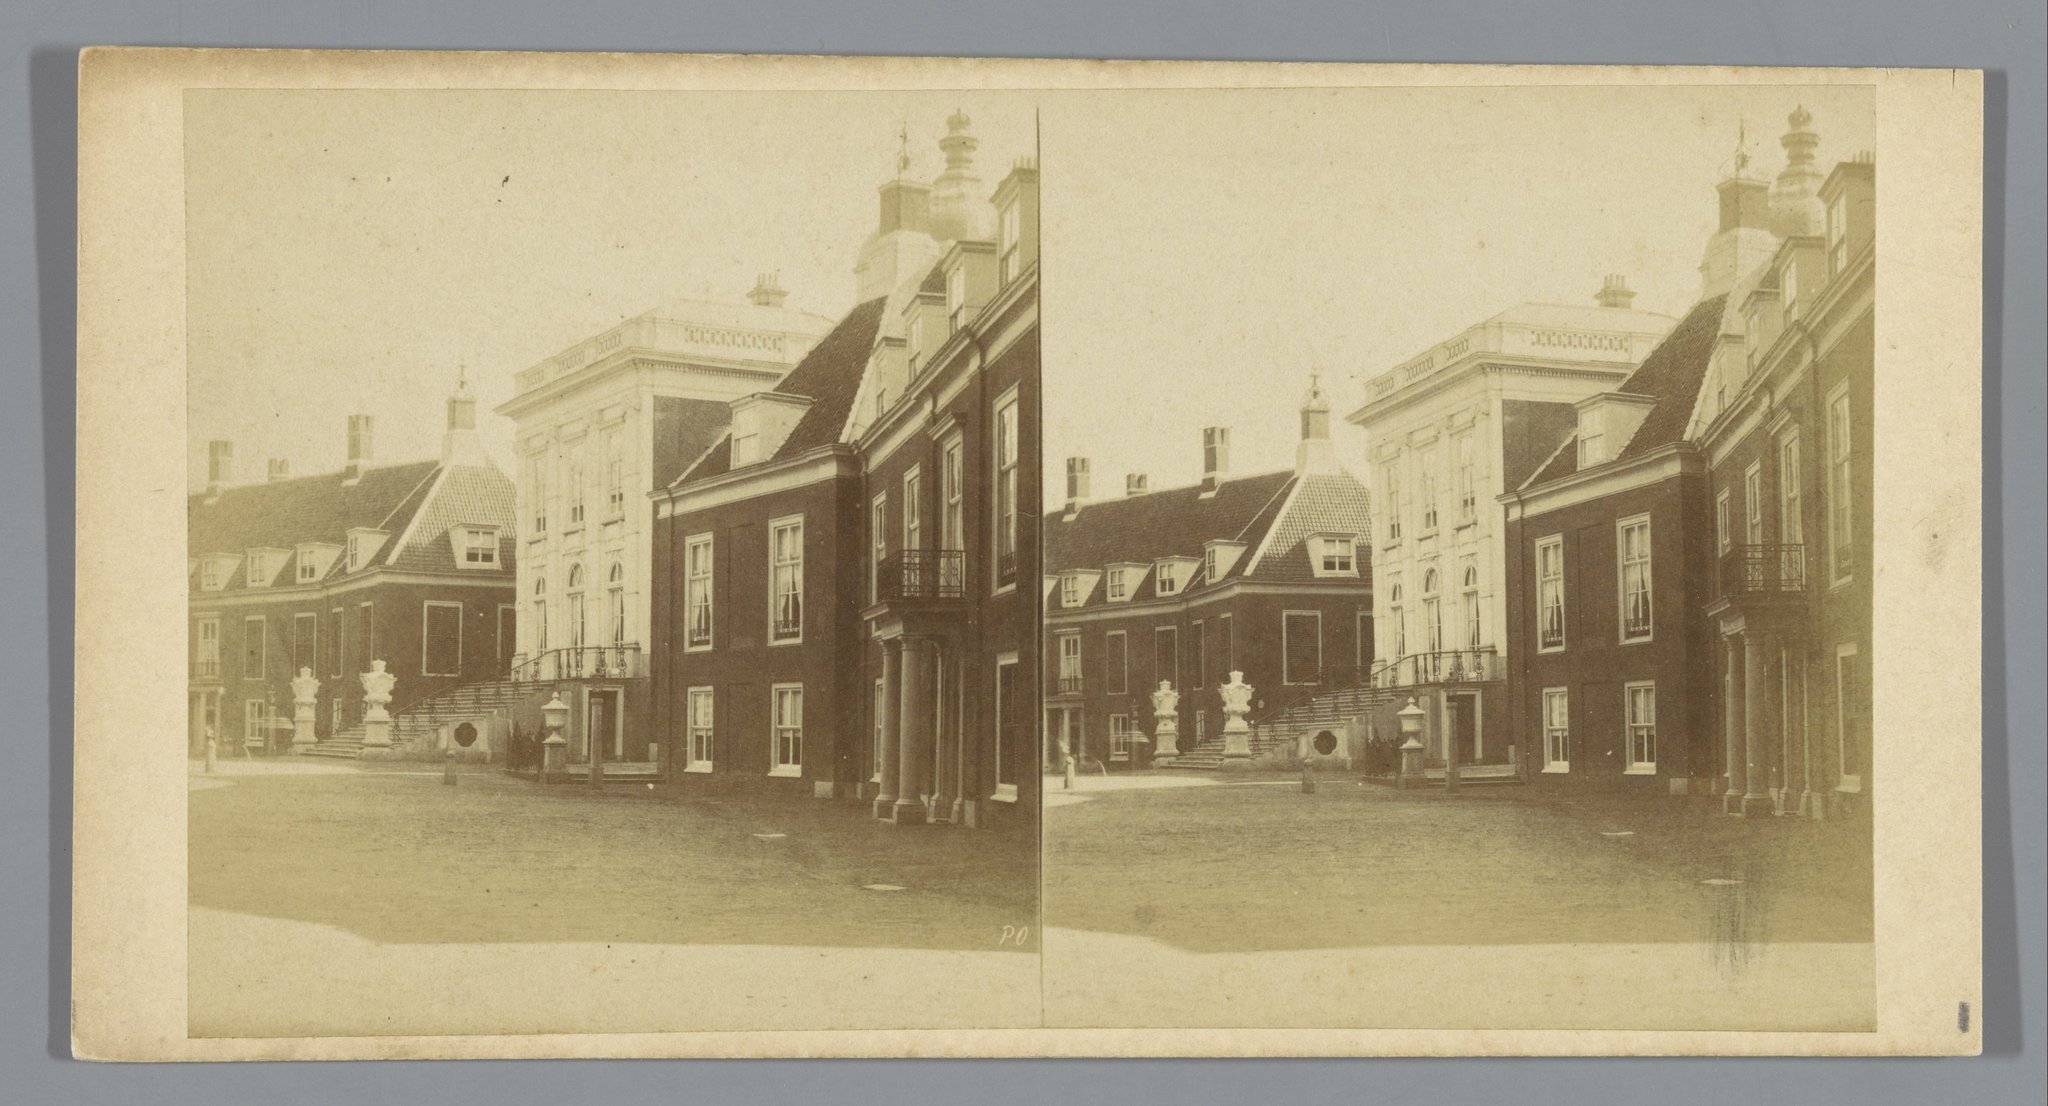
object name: stereograph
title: Huis ten Bosch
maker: pieter oosterhuis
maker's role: draughtsman, print maker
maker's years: 1816-1885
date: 1857-1863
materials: cardboard, paper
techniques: albumen print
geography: netherlands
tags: palace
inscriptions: number: ‘No. 191.’